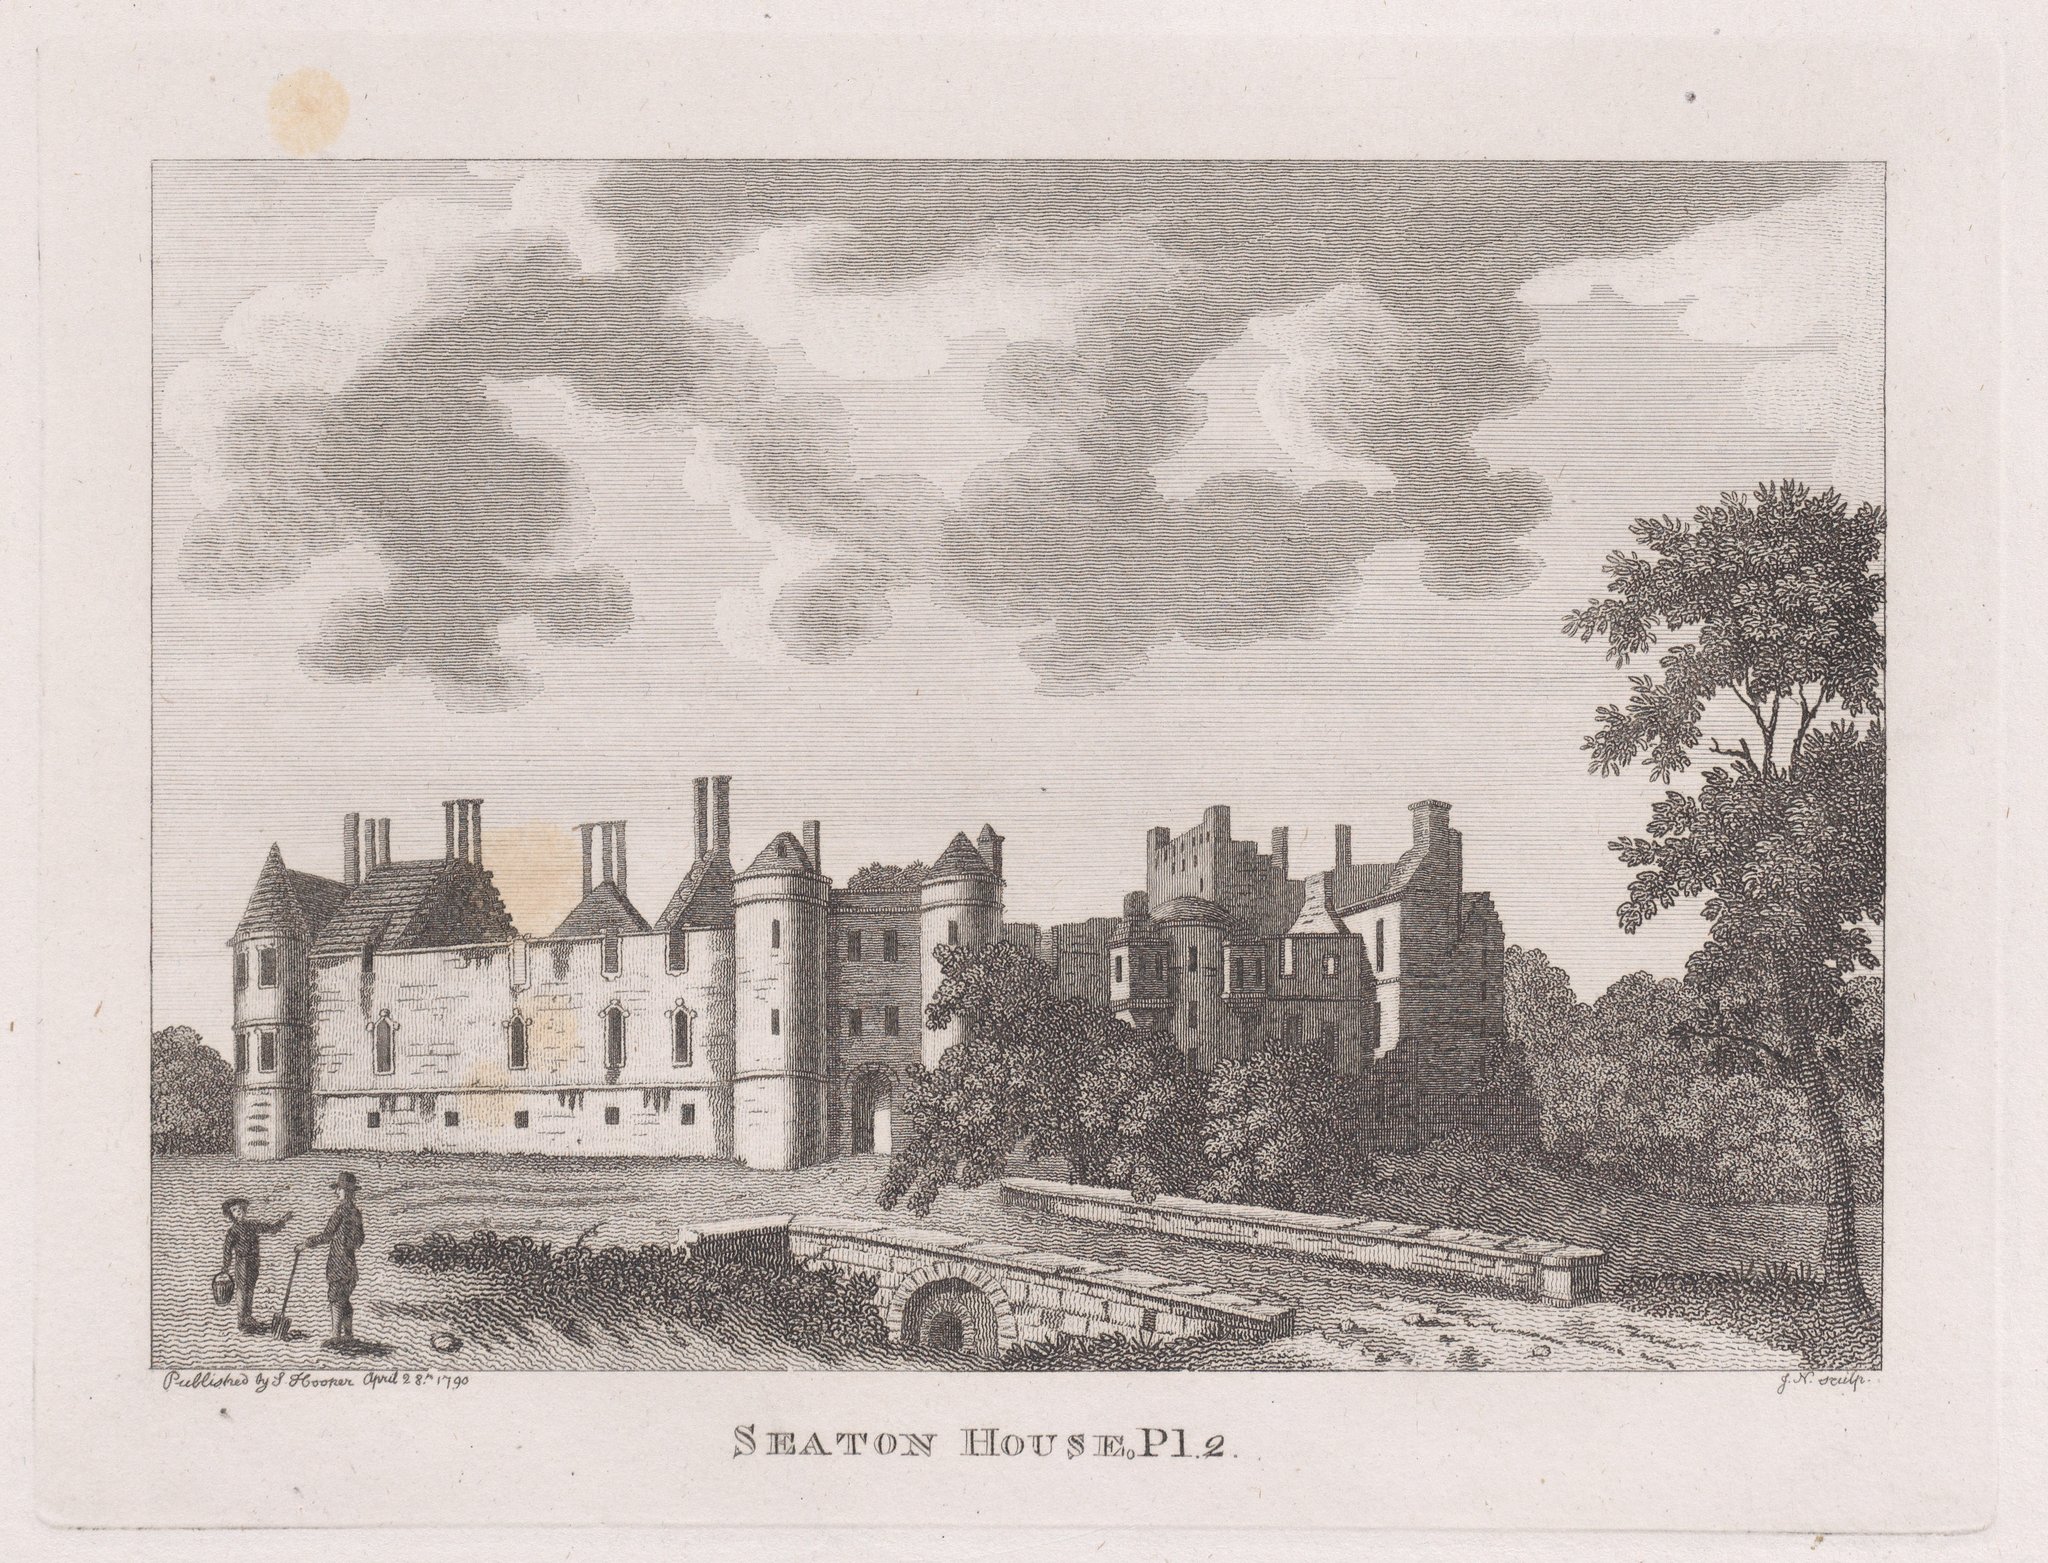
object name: print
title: Seaton House, pl. 2, Edinburghshire (from Antiquities of Scotland, volume 1)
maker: james newton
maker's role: artist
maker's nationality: british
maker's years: 1748-1805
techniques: engraving, etching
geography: england